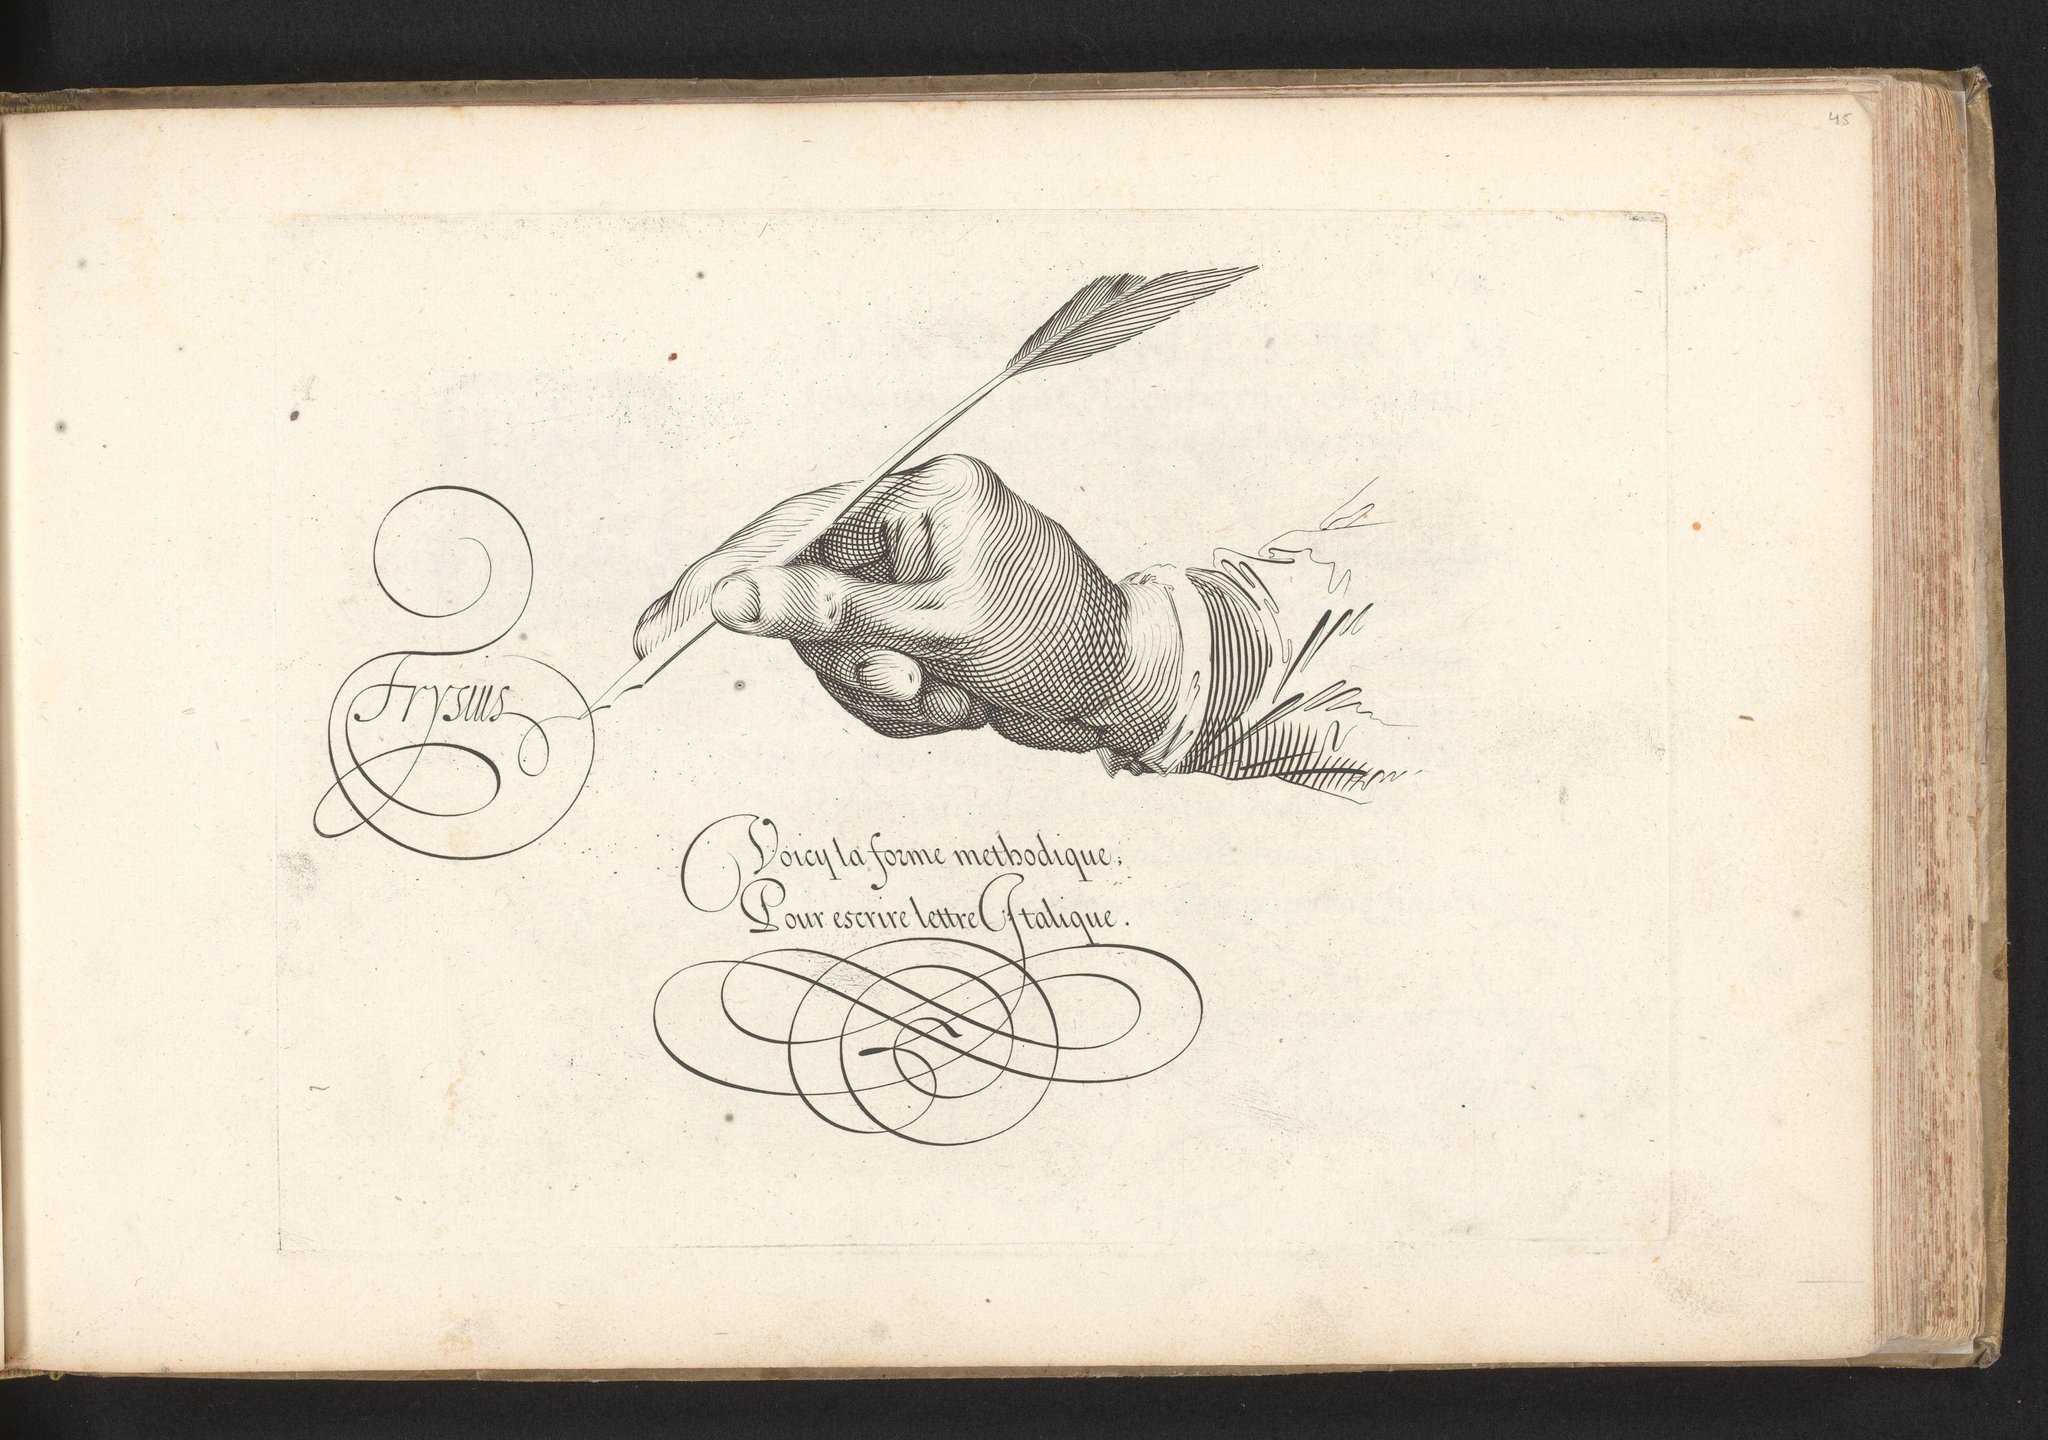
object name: print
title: Thrésor litéraire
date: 1605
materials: paper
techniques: engraving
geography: rotterdam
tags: handwriting, writing as activity, quill, calligraphy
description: Rechterhand met ganzenpen, Frysius schrijvend. Met tweeregelig onderschrift in het Frans: Voicy la forme methodique ... De prent maakt deel uit van een album.